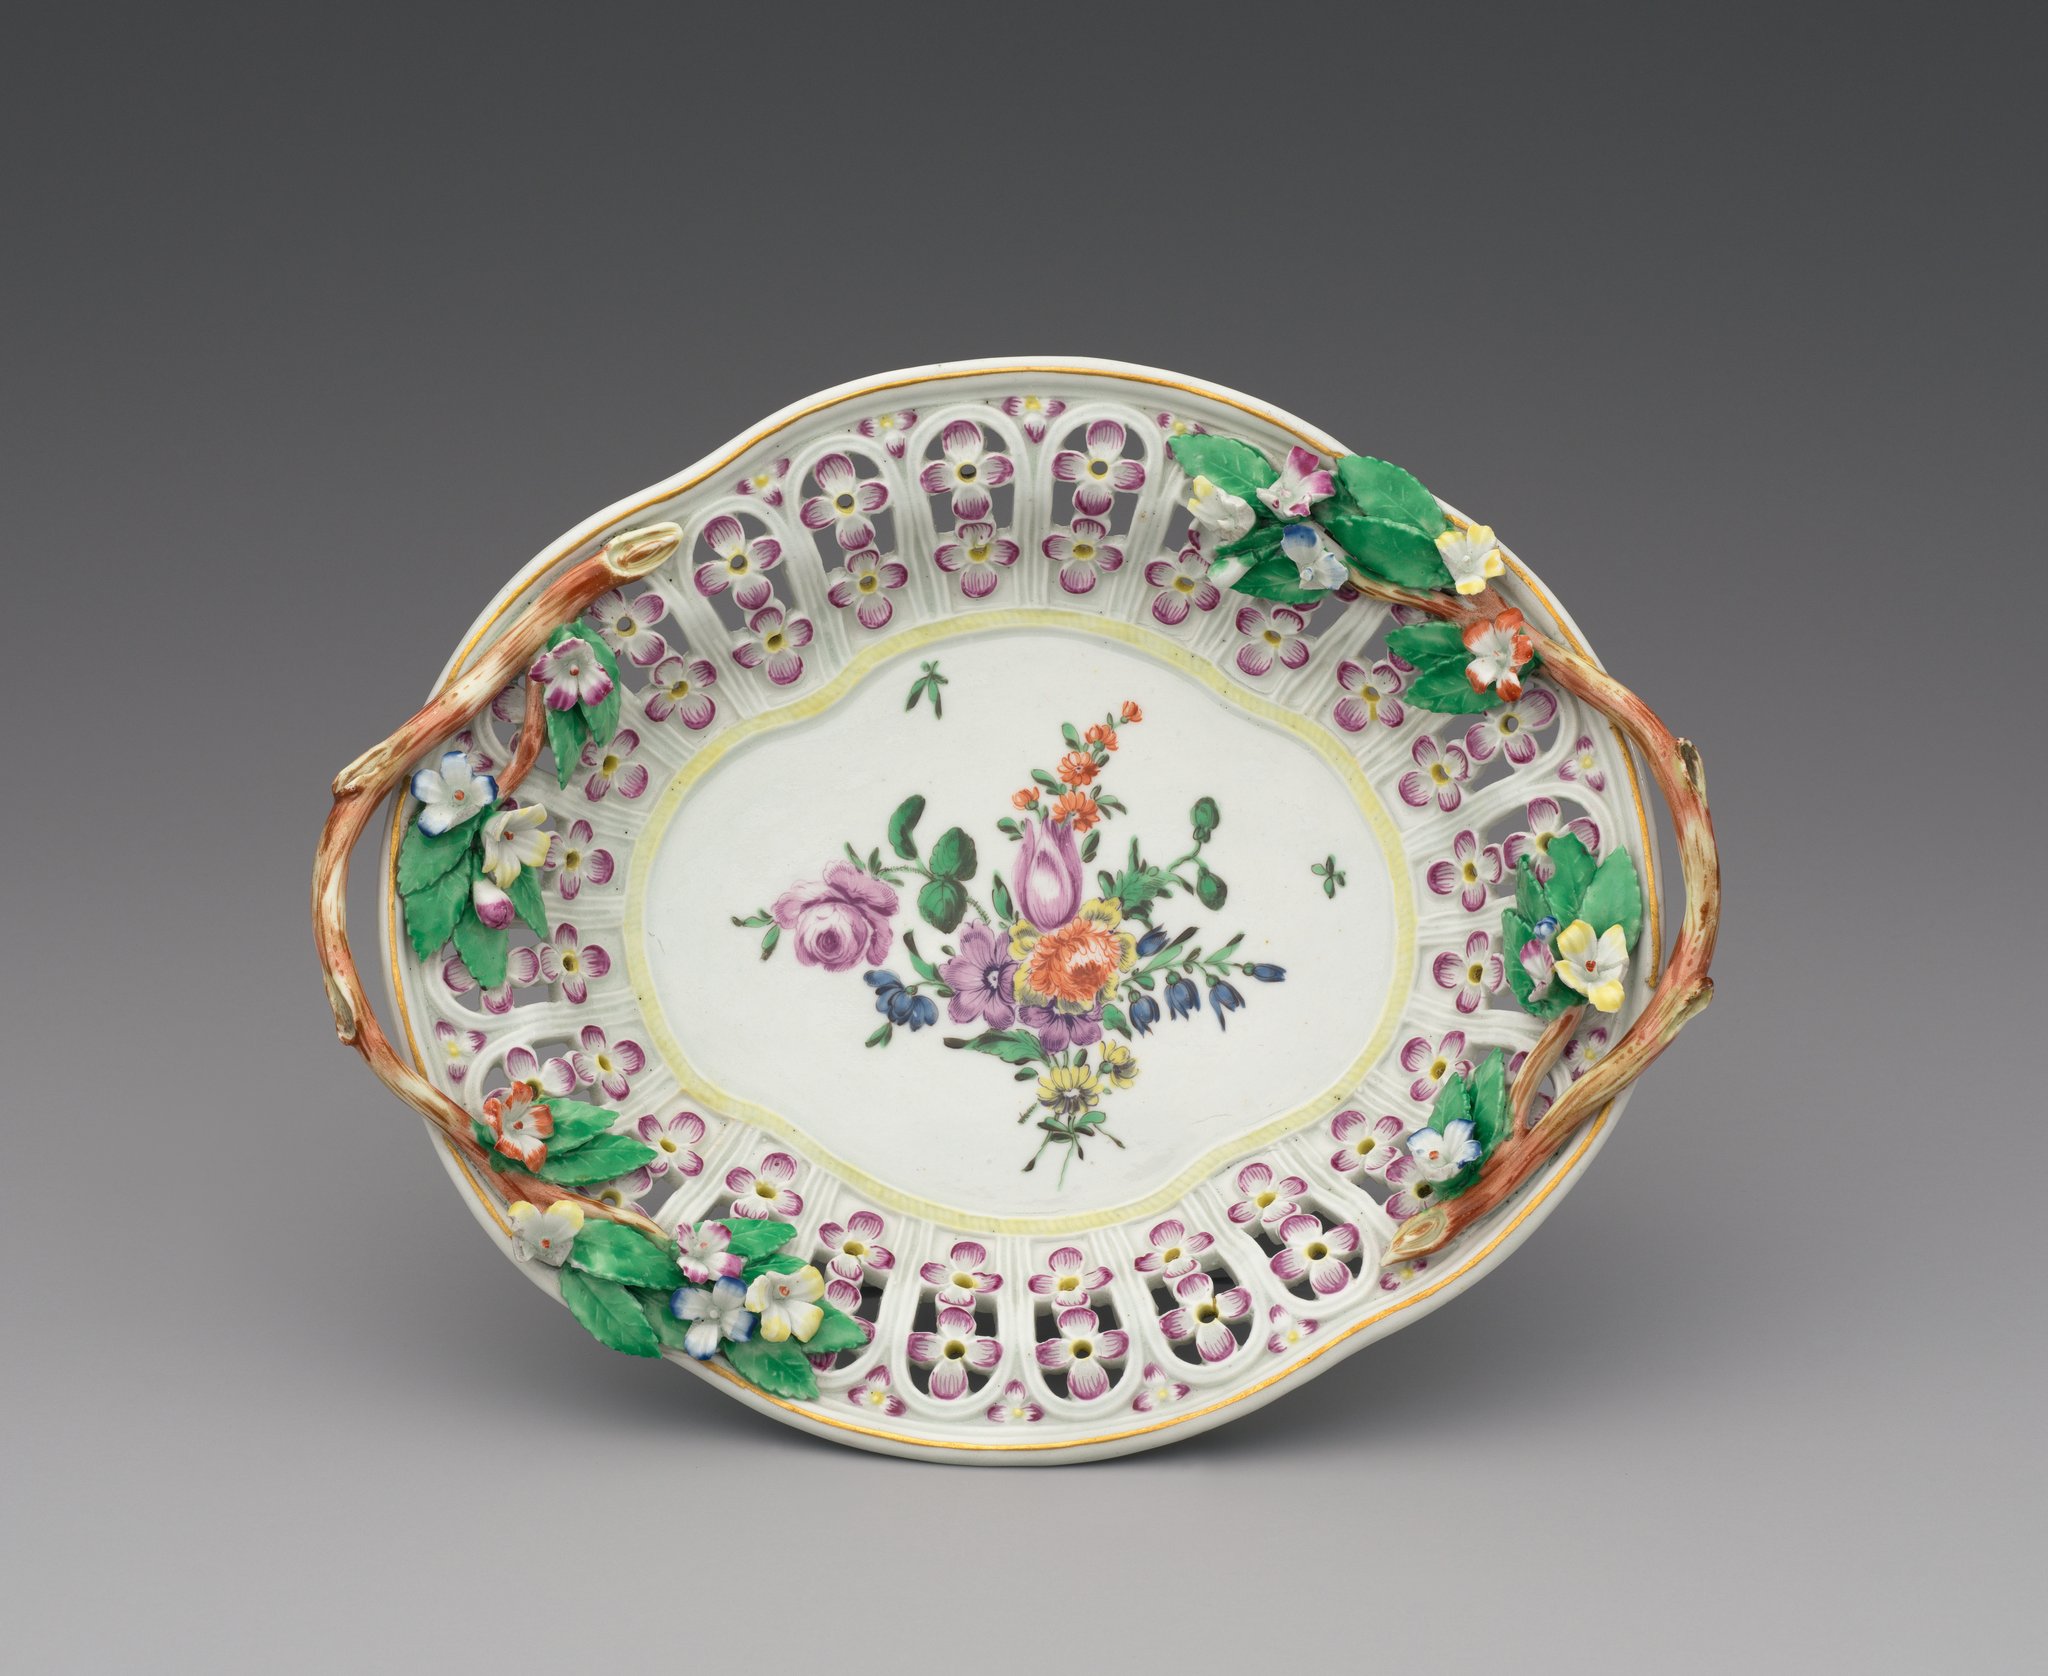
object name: tray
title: Tray for a dessert basket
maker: worcester factory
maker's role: factory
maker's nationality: british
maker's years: 1751-2008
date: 1770-1780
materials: soft paste porcelain